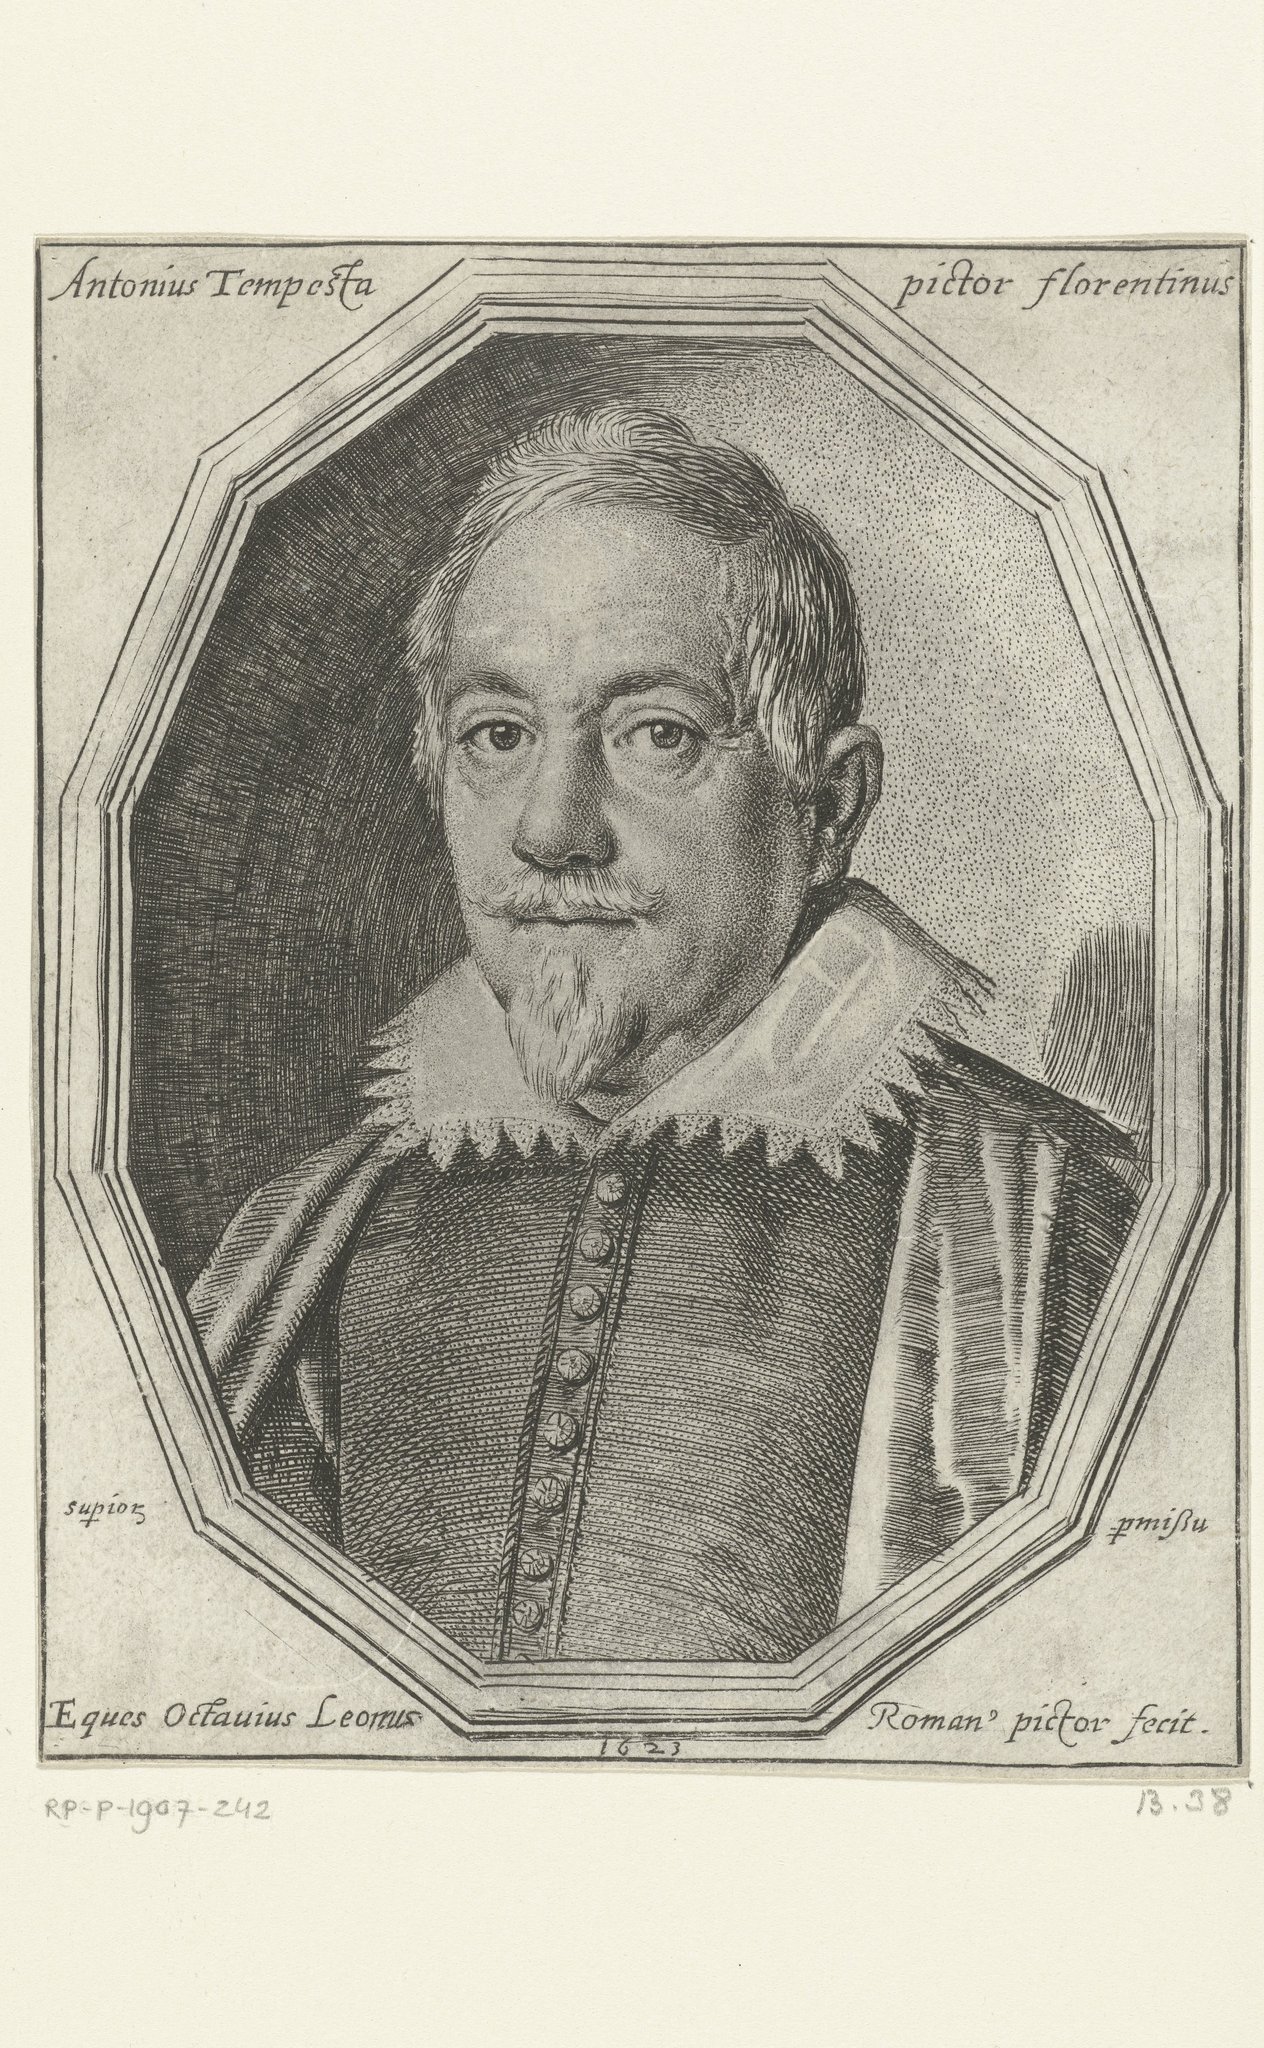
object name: print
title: Portret van Antonio Tempesta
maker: ottavio mario leoni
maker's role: draughtsman, print maker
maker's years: 1578-1630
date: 1623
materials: paper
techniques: etching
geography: italy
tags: painter, print maker, draughtsman, antonio tempesta, portrait, self-portrait of artist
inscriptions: collector's mark: Lugt 2228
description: Onderdeel van een serie van mogelijk tien prenten met bergachtige landschappen met reizigers. Prent nummer 10 in British Museum: 1878,0713.2123.